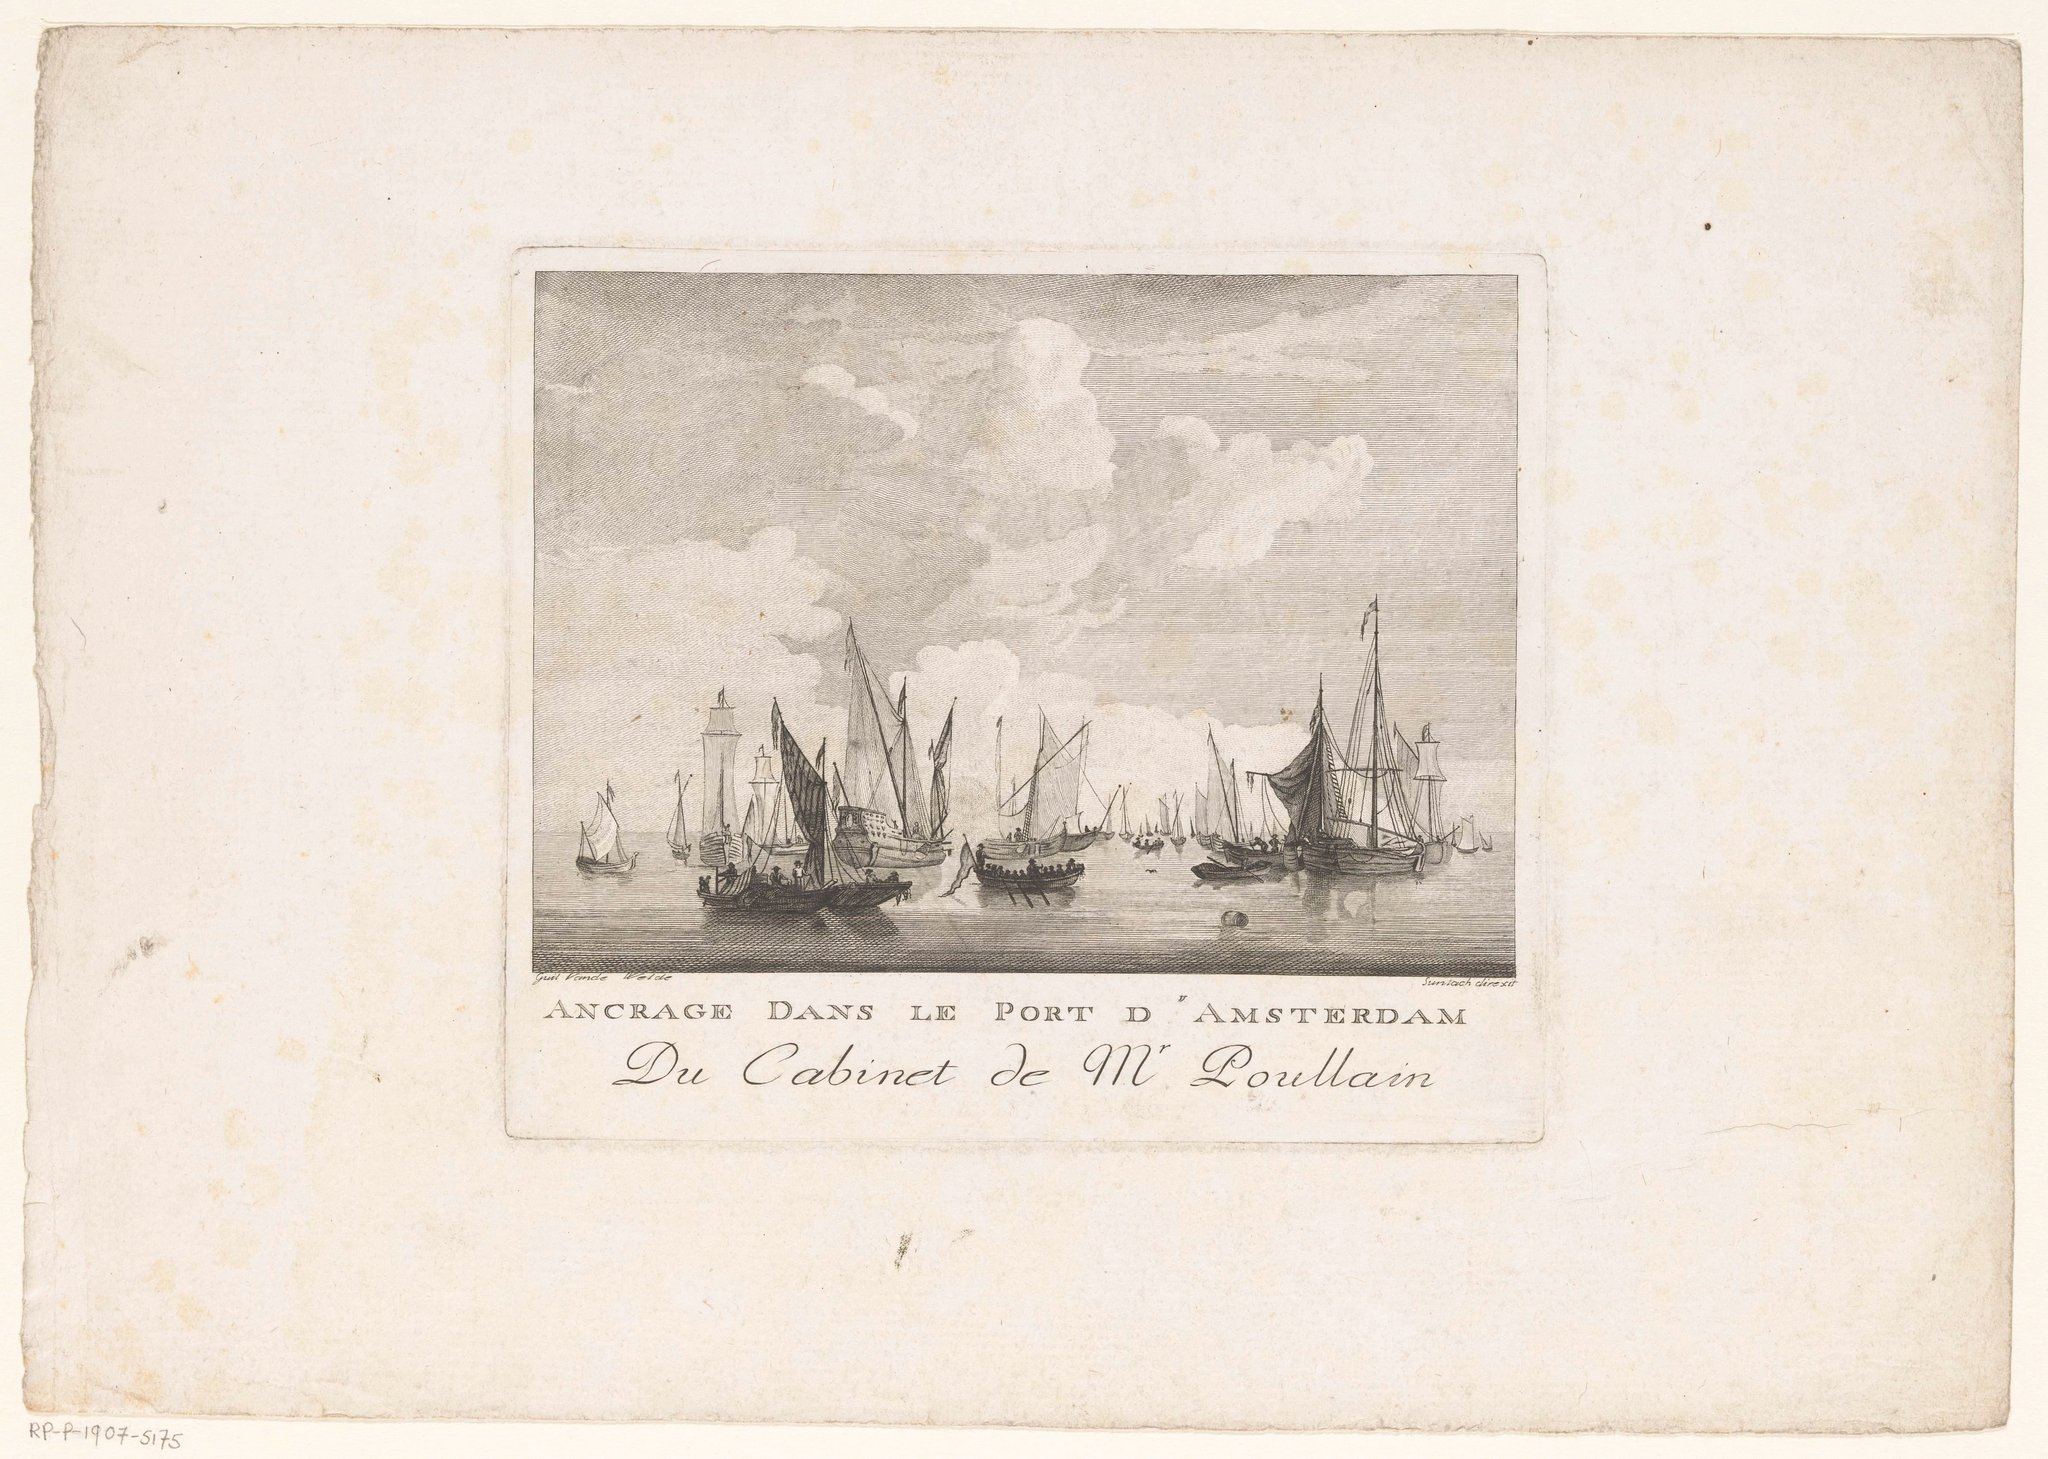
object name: print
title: Du Cabinet de Mr Poullain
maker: Anonymous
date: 1754-1842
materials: paper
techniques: engraving, etching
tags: ships (in general), sea (seascape), amsterdam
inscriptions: collector's mark: Lugt 2228